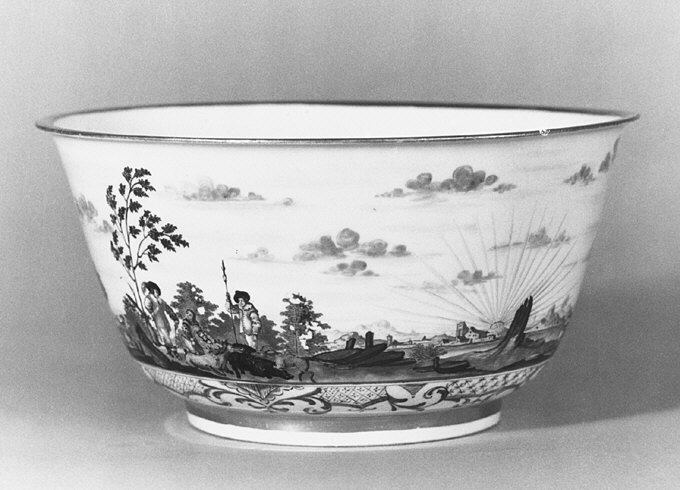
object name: bowl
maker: meissen manufactory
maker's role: manufactory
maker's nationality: german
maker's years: 1710-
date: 1726-1728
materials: hard paste porcelain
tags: human figures,animals,sun,trees